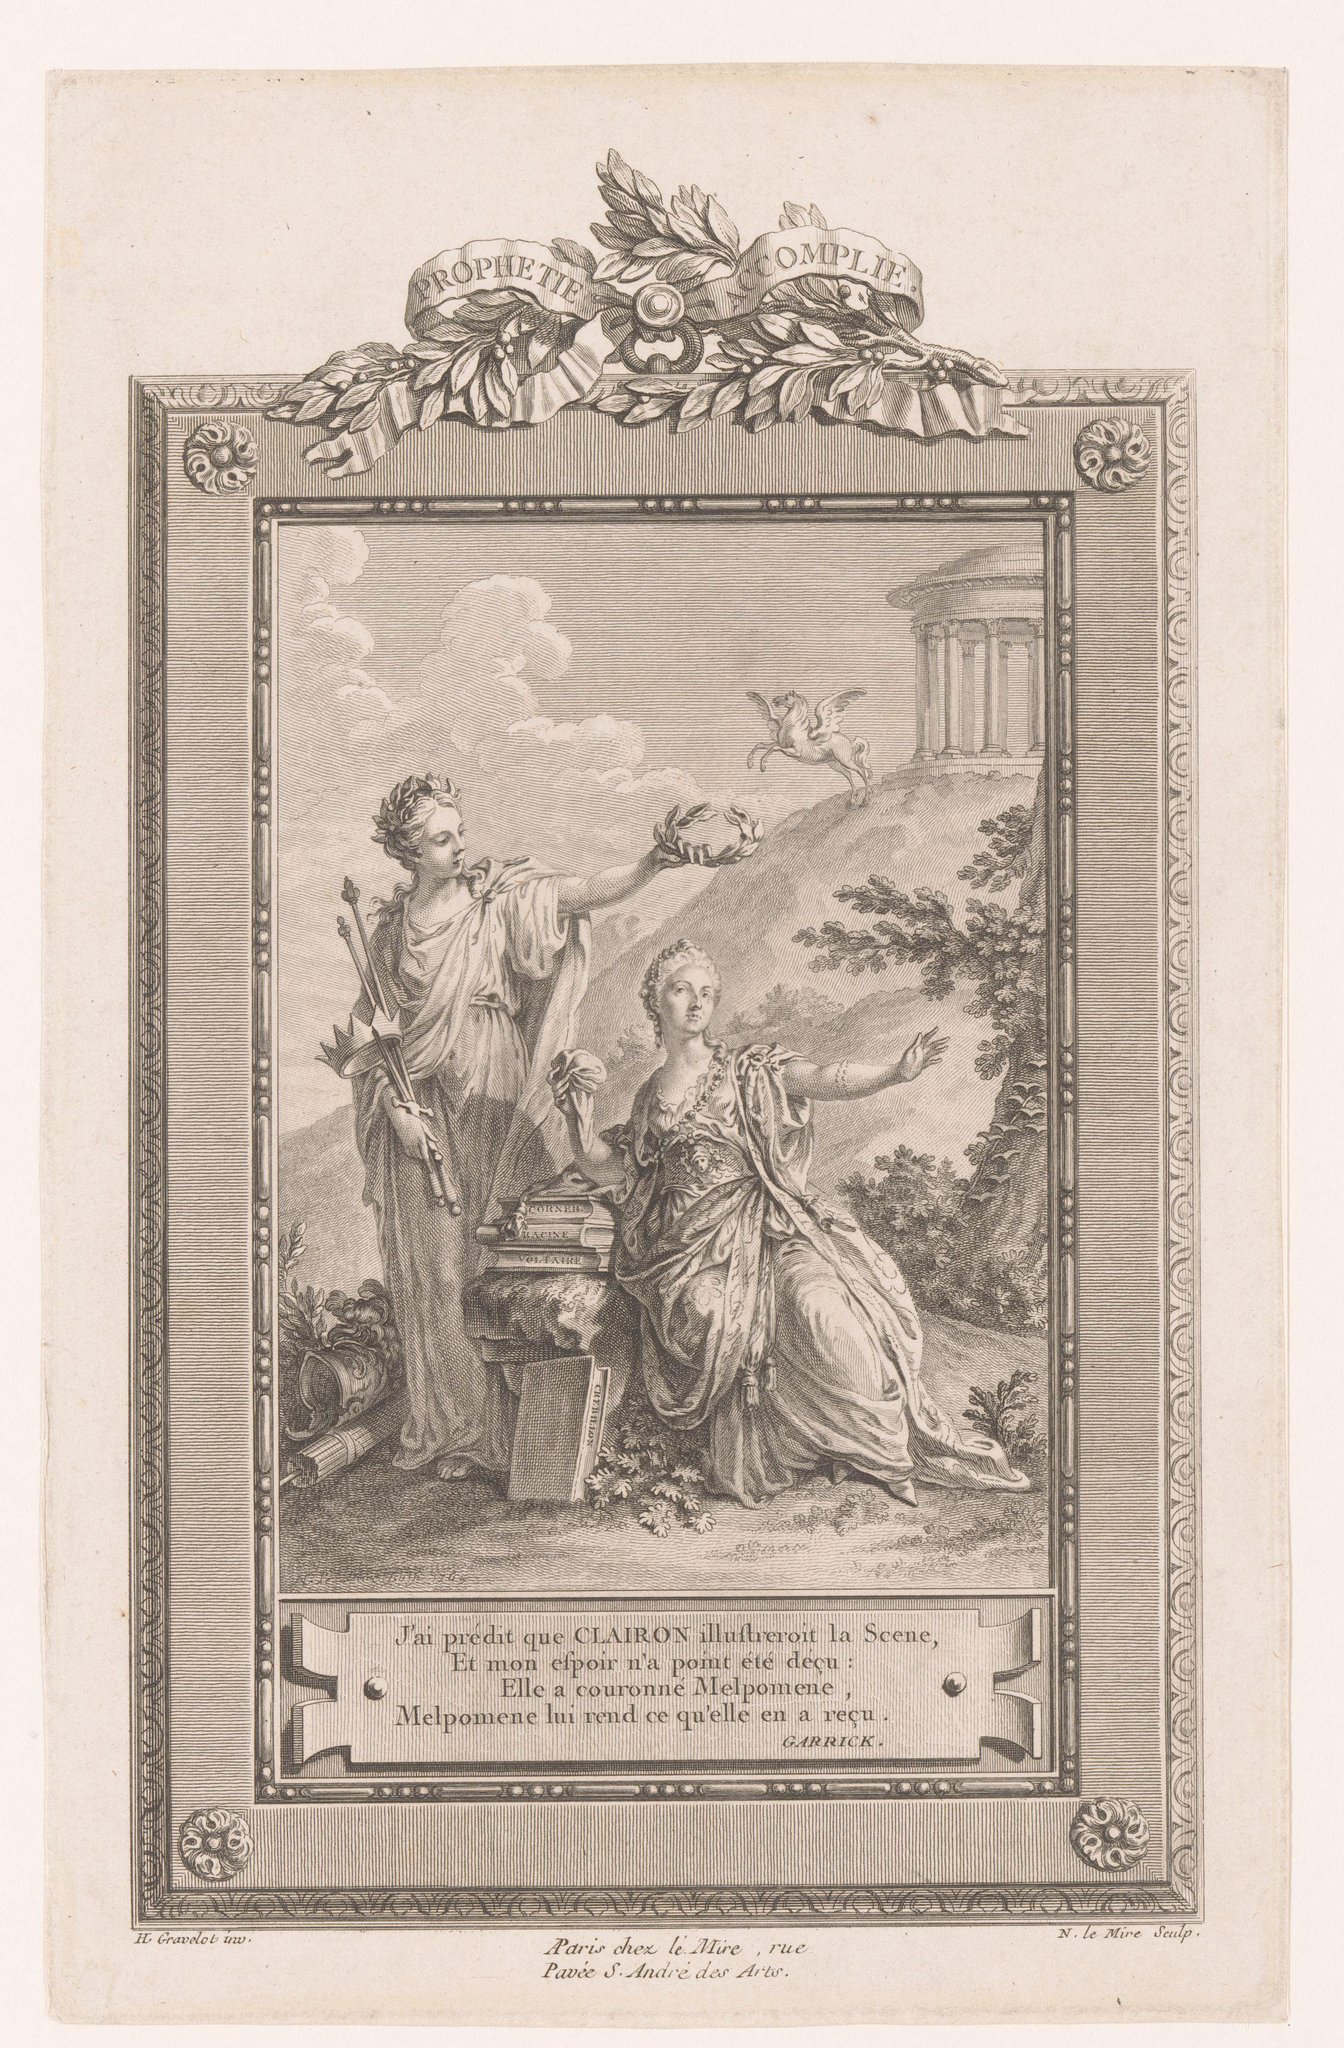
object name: print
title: Prophetie accomplie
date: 1765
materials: paper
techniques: engraving, etching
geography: paris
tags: paris, crown (symbol of sovereignty), melpomene (one of the muses); 'melpomene' (ripa)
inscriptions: collector's mark: Lugt 240